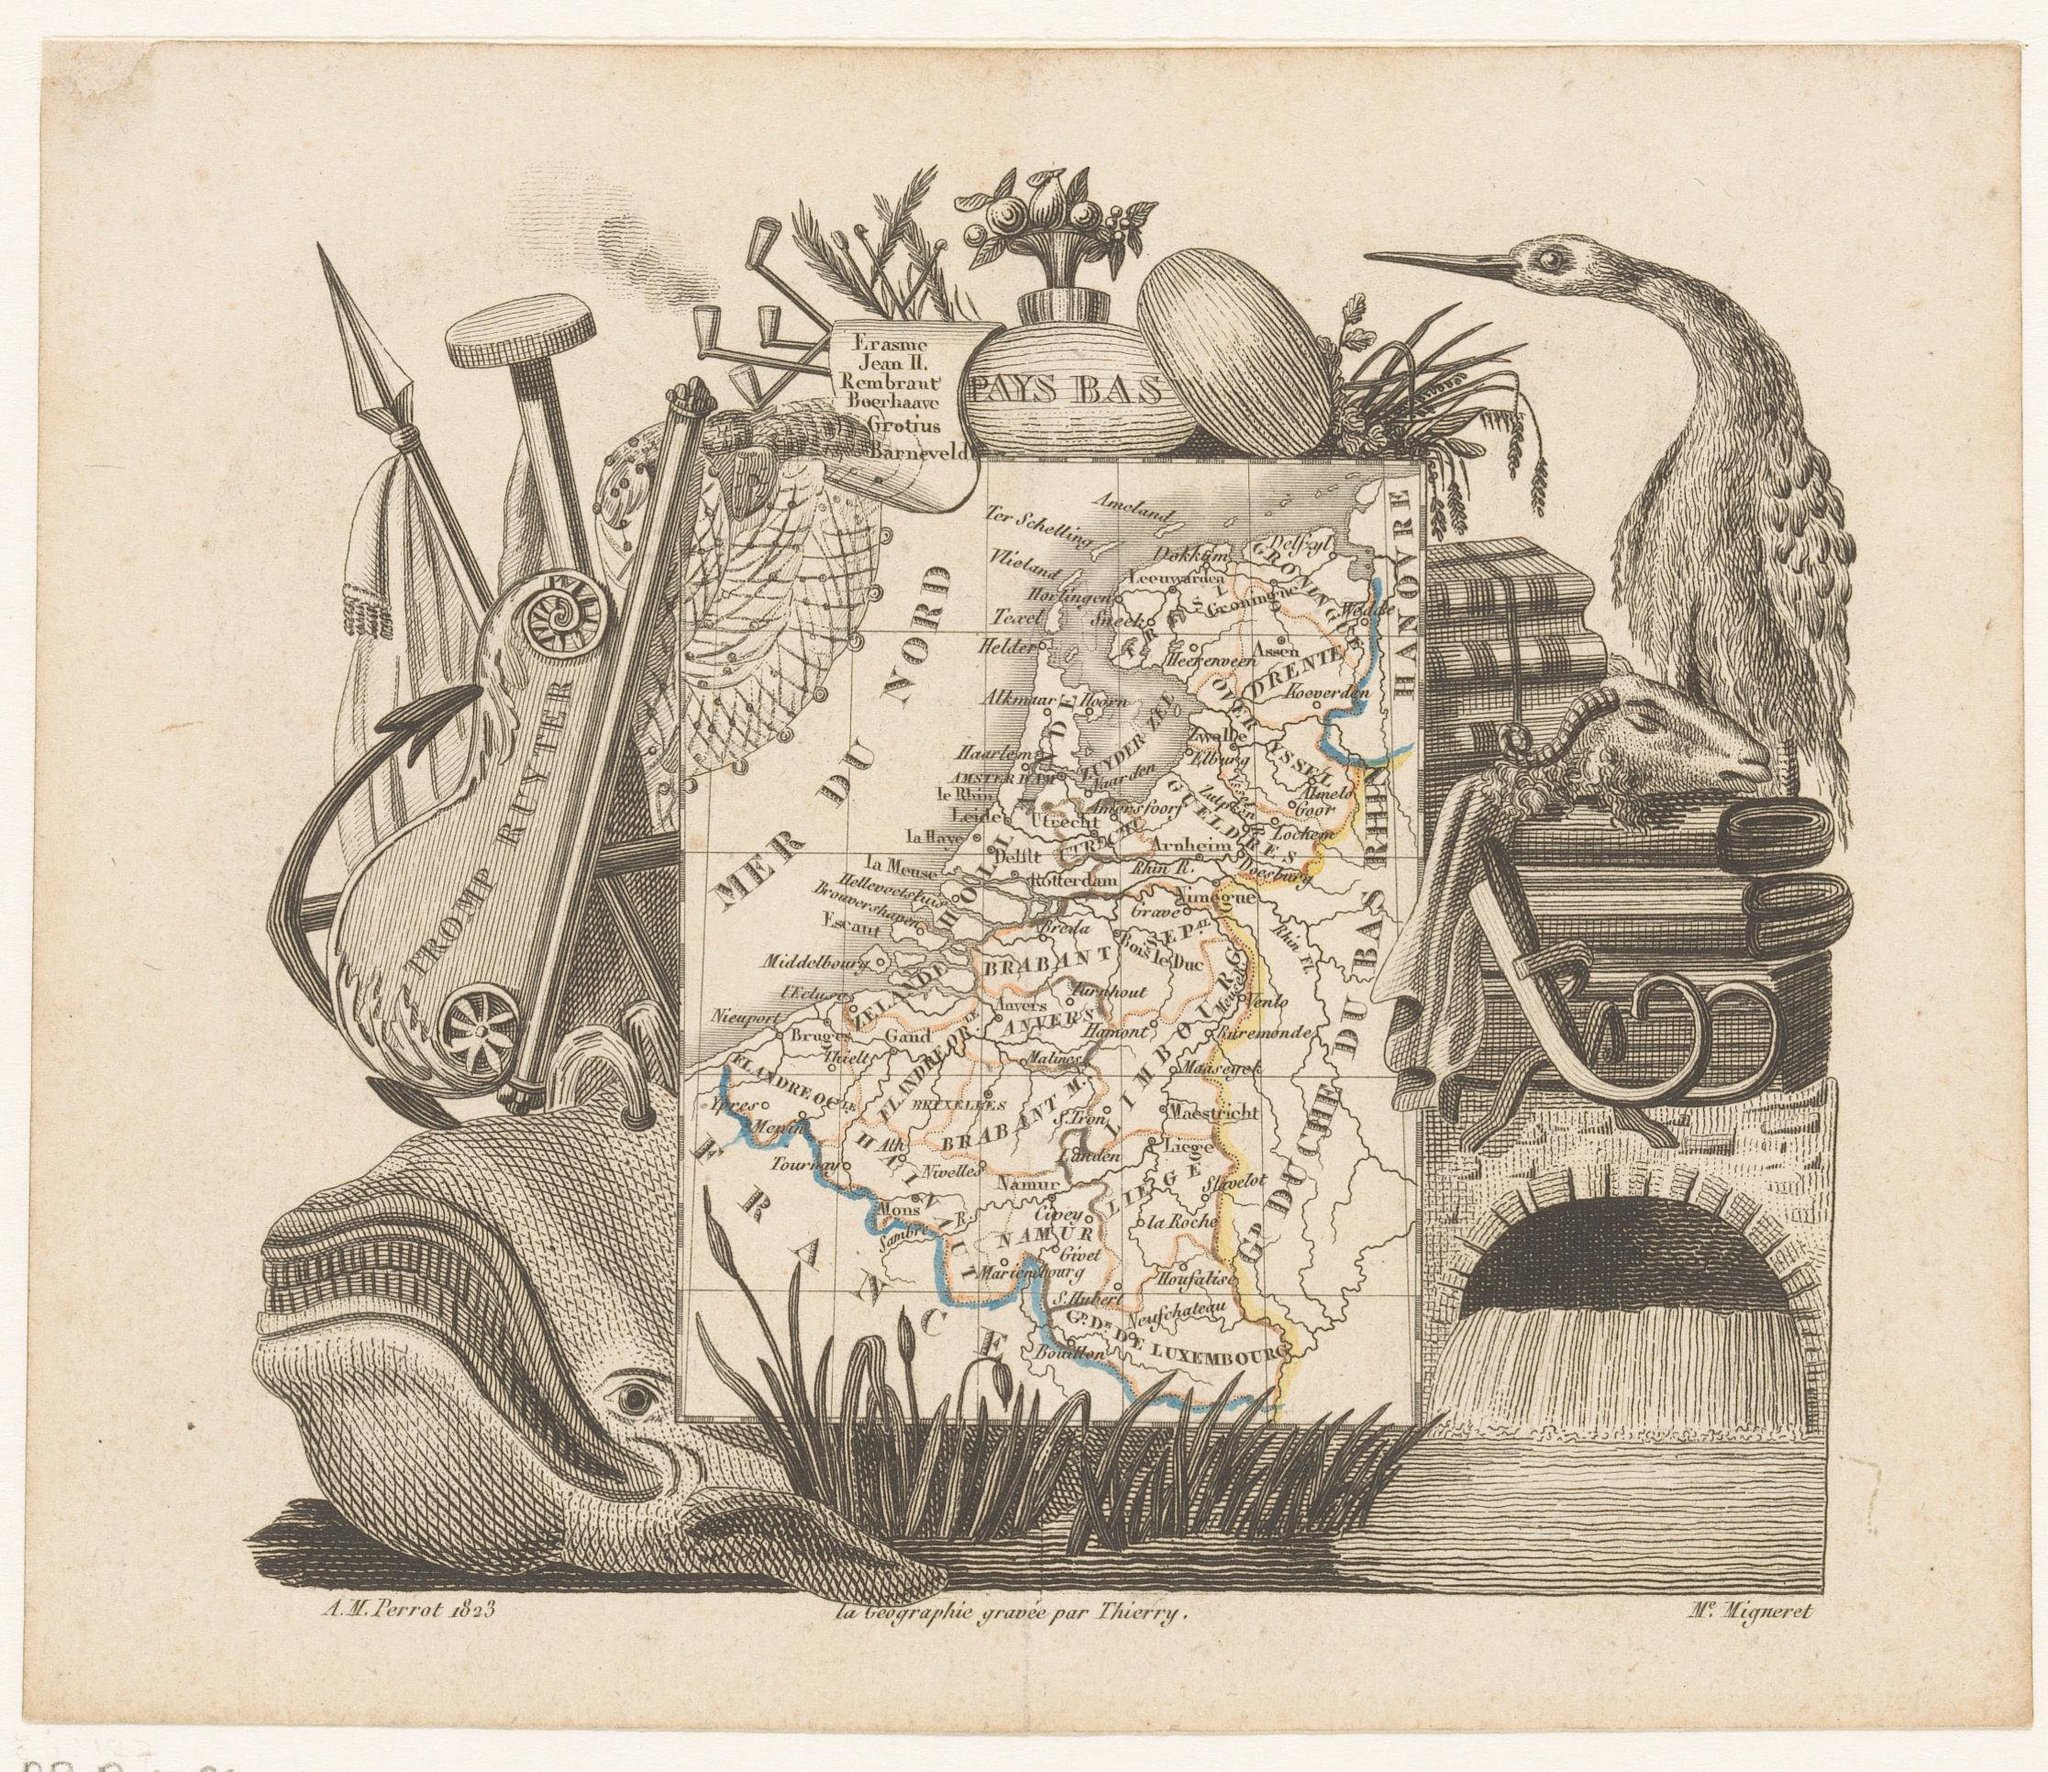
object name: print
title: Kaart van Nederland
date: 1823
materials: paper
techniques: etching, hand coloring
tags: maps of separate countries or regions, symbols of particular nations, states, districts, etc., swimming mammals: whale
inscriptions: collector's mark: Lugt 2760, collector's mark: Lugt 2228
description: Kaart van Nederland, geplaatst tegen een walvis en een brug of dam met daarop boeken geplaatst. Om de kaart heen zijn instrumenten, wapens, schaatsen, pijpen, een reiger en overige objecten weergegeven.